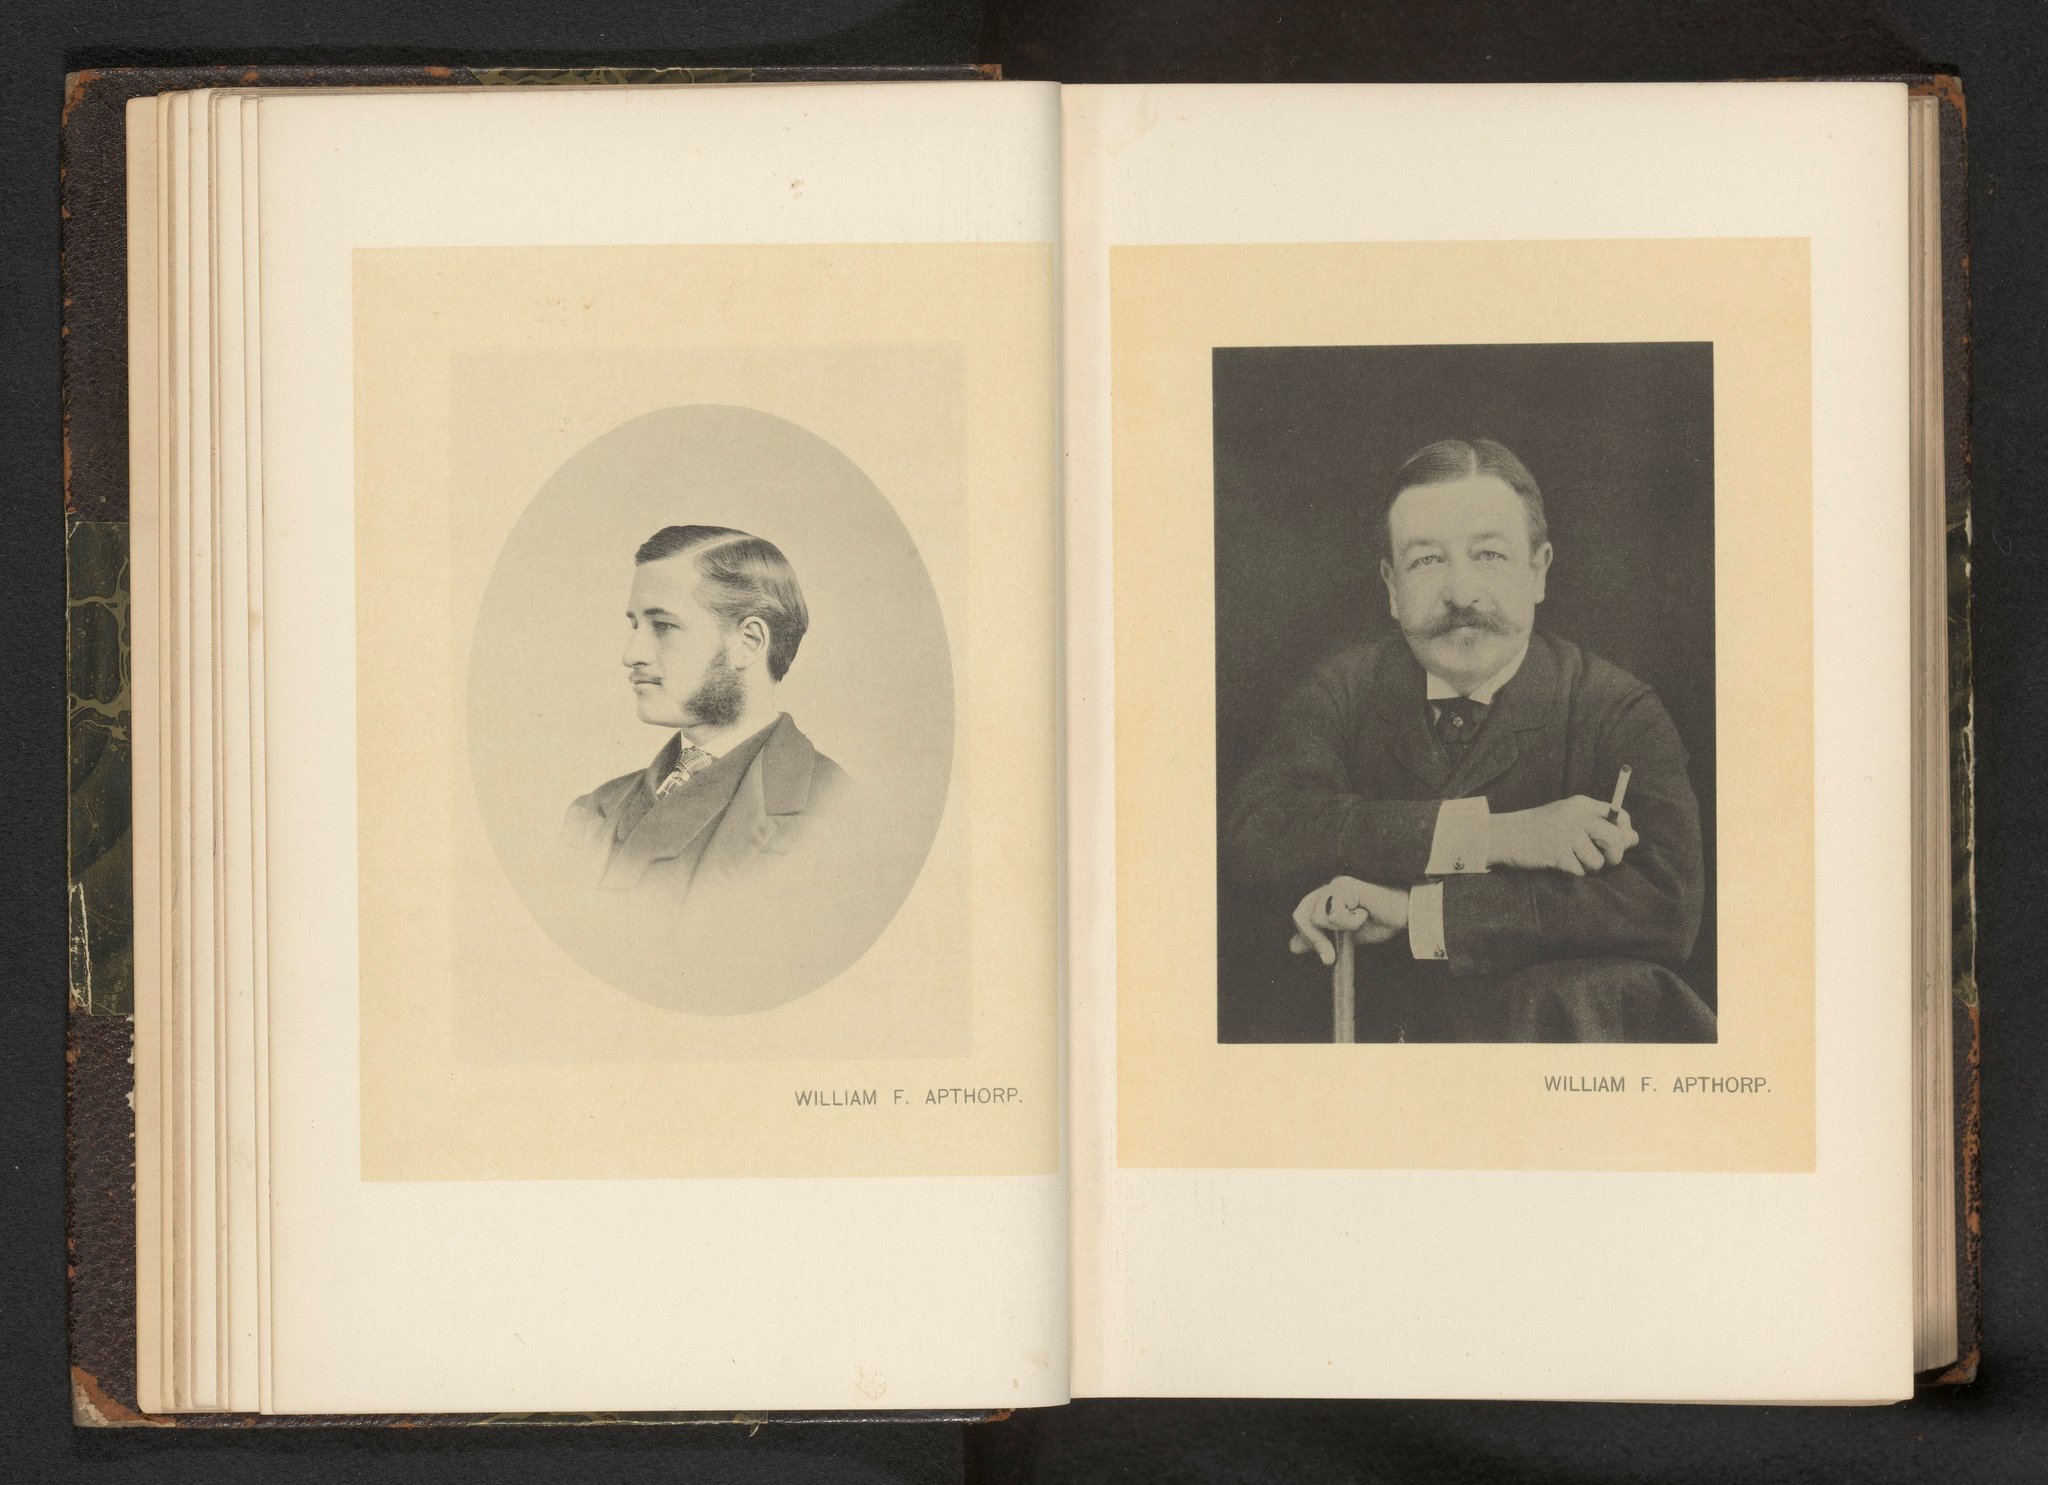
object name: photomechanical print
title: William F. Apthorp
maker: Anonymous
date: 1889-1894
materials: paper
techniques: photoaquatint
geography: boston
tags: portrait of a writer